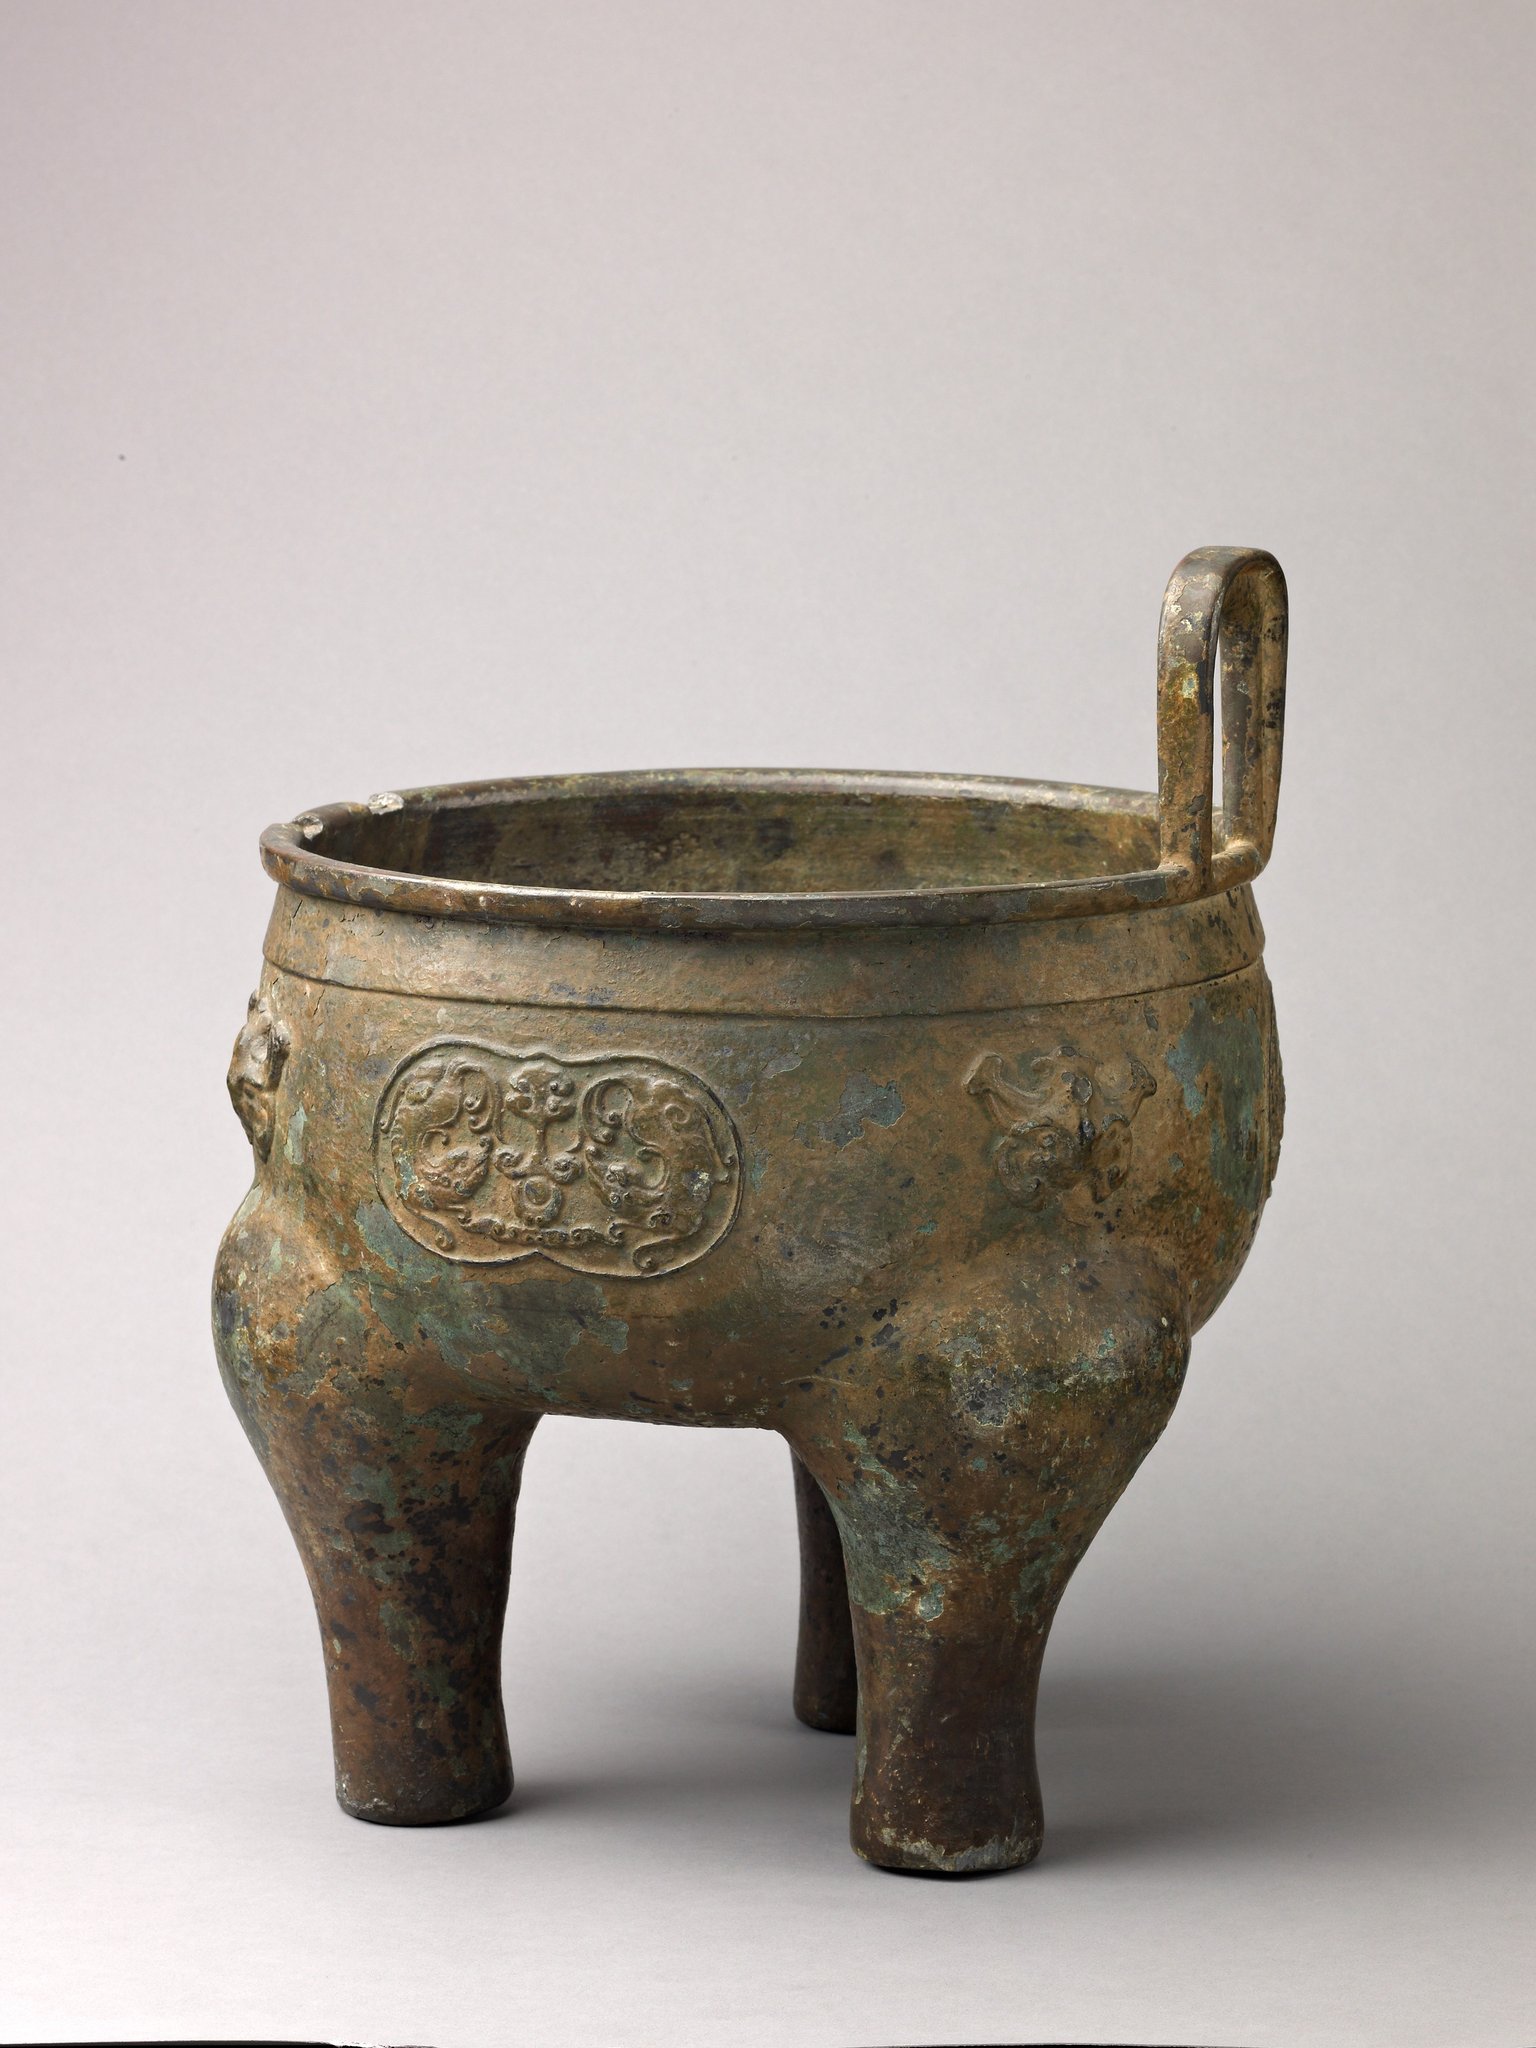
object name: censer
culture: chinese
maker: chinese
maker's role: artist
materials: bronze